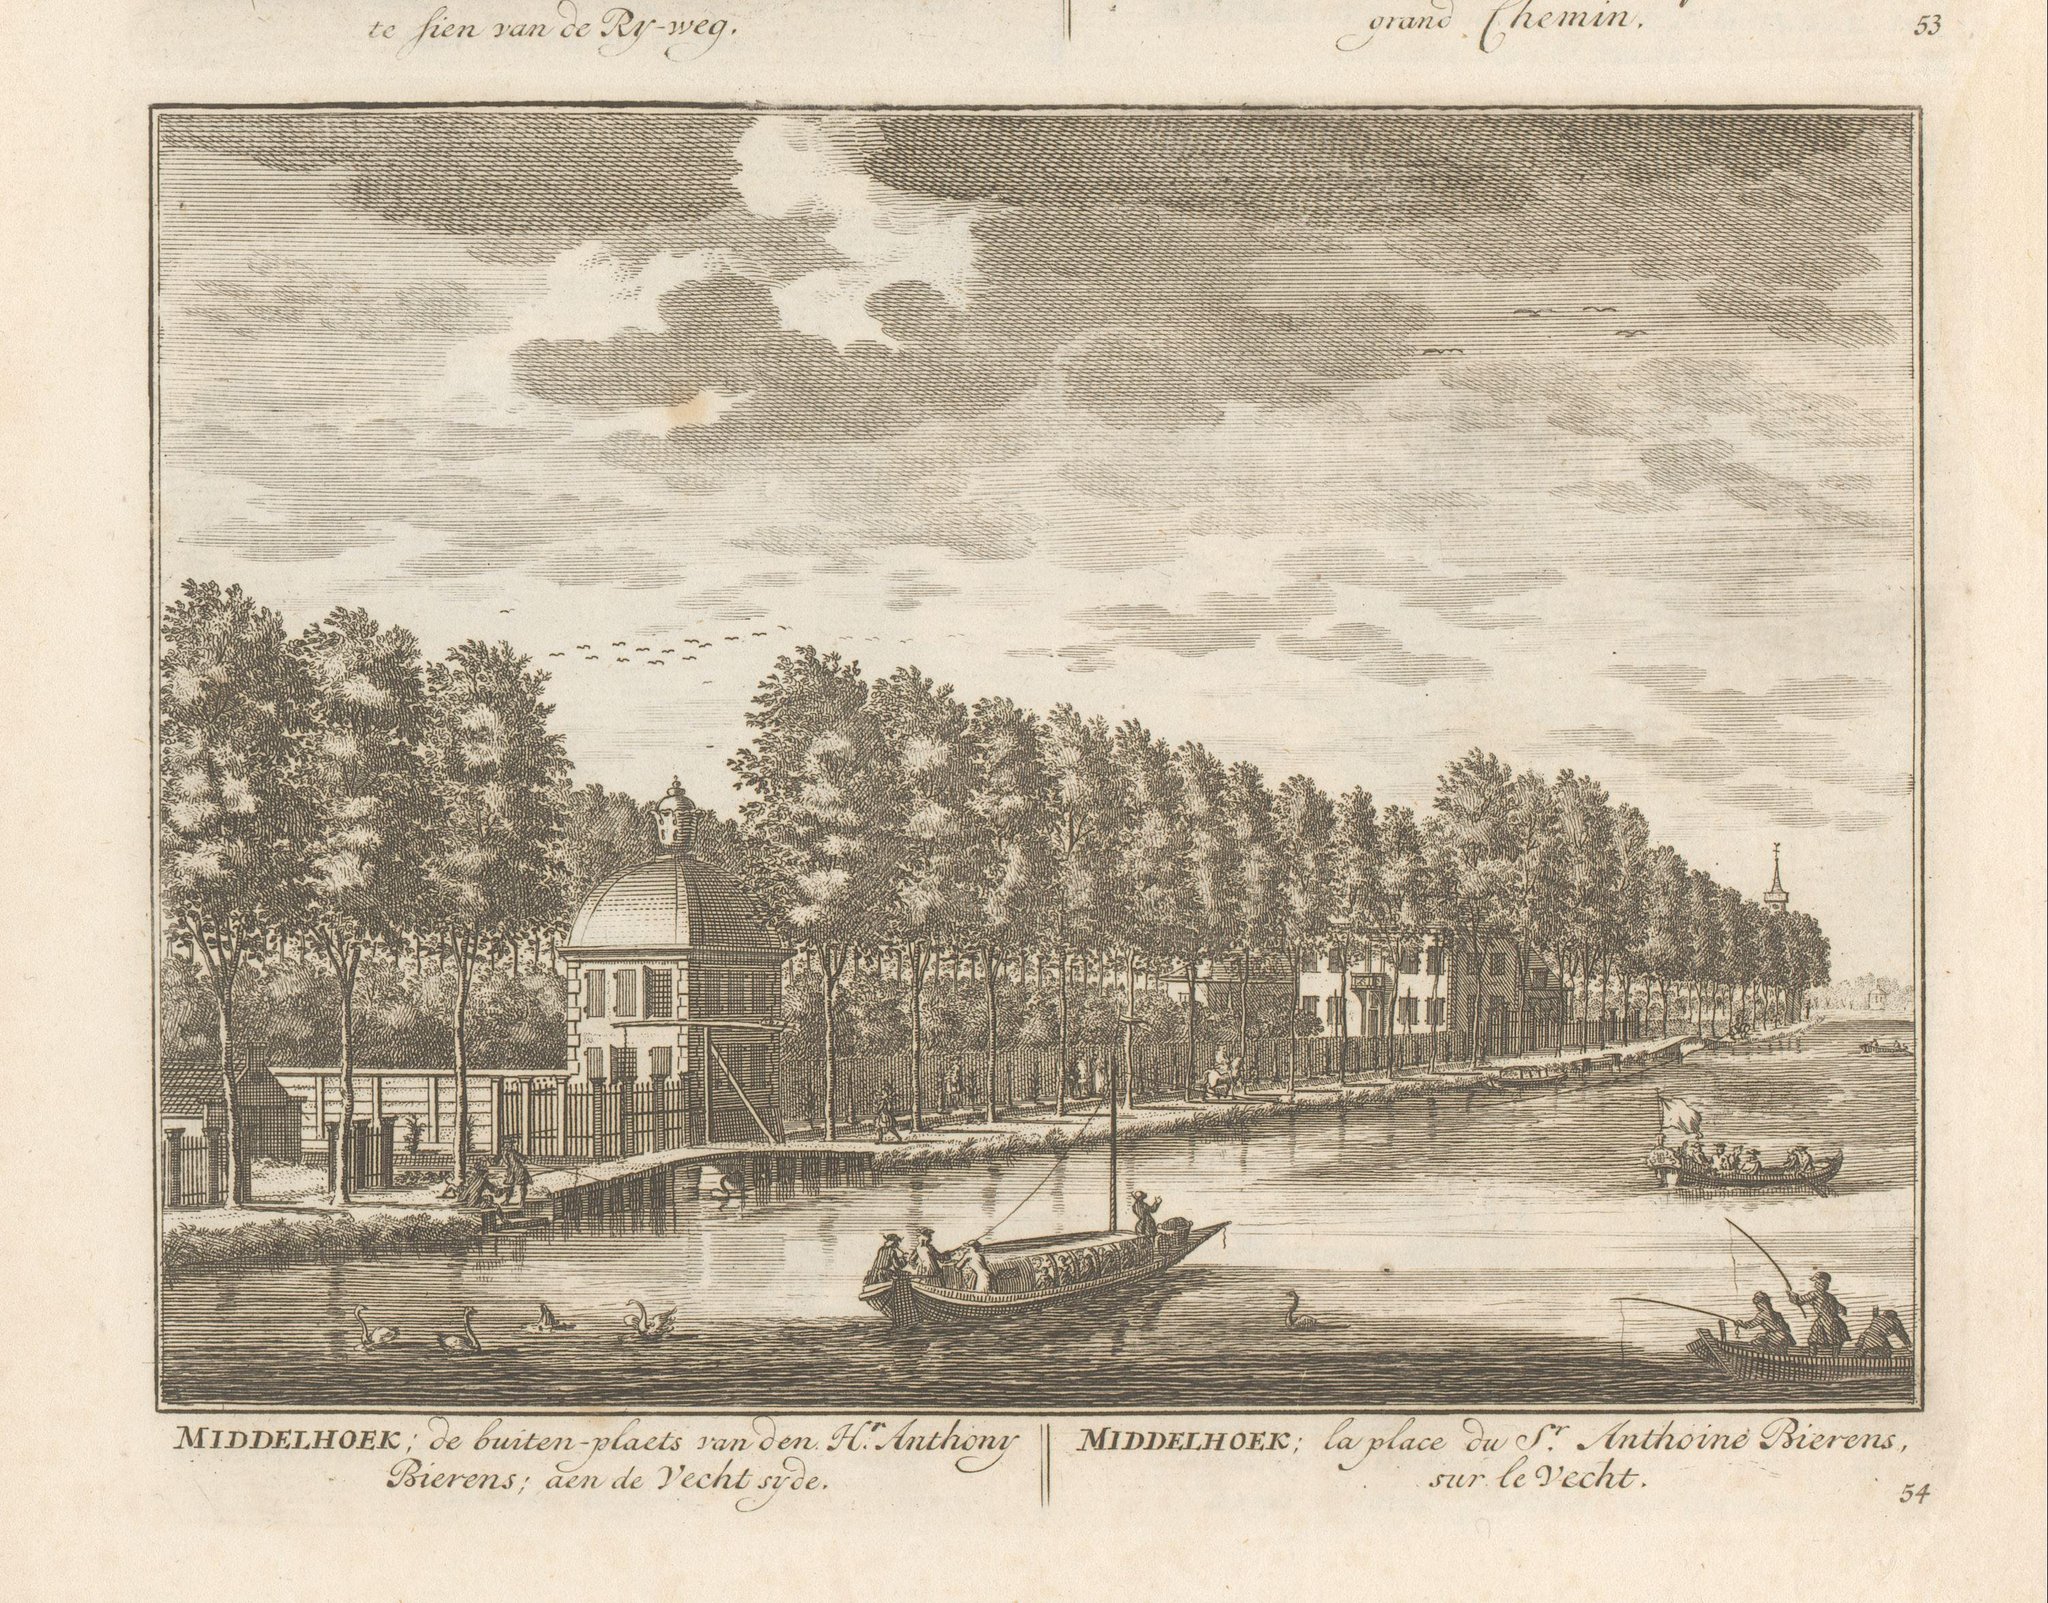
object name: book illustration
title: Middelhoek: de buiten-plaetse van den H. Anthony Bierens: aen de Vechtsyde / Middelhoek; l place du S. Anthoine Bierens, sur le Vecht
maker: daniël stopendaal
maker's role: print maker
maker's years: 1672-1726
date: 1790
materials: paper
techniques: engraving, etching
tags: river (+ landscape with figures, staffage), country-house, vecht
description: Prent gebruikt in: Leth, Andries de. De zegepraalende Vecht, vertoonende verscheidene gesichten van lustplaatsen, heeren huysen en dorpen, beginnende van Uitrecht en met Muyden besluytende (...). Amsterdam: Weduwe Nicolaus Visscher, 1719. Prent ook gebruikt in: Brouërius van Nidek, Matthaeus. De Vechtstroom, van Utrecht tot Muiden (...). Amsterdam: H. Gartman, W. Vermandel en J.W. Smit, 1790.